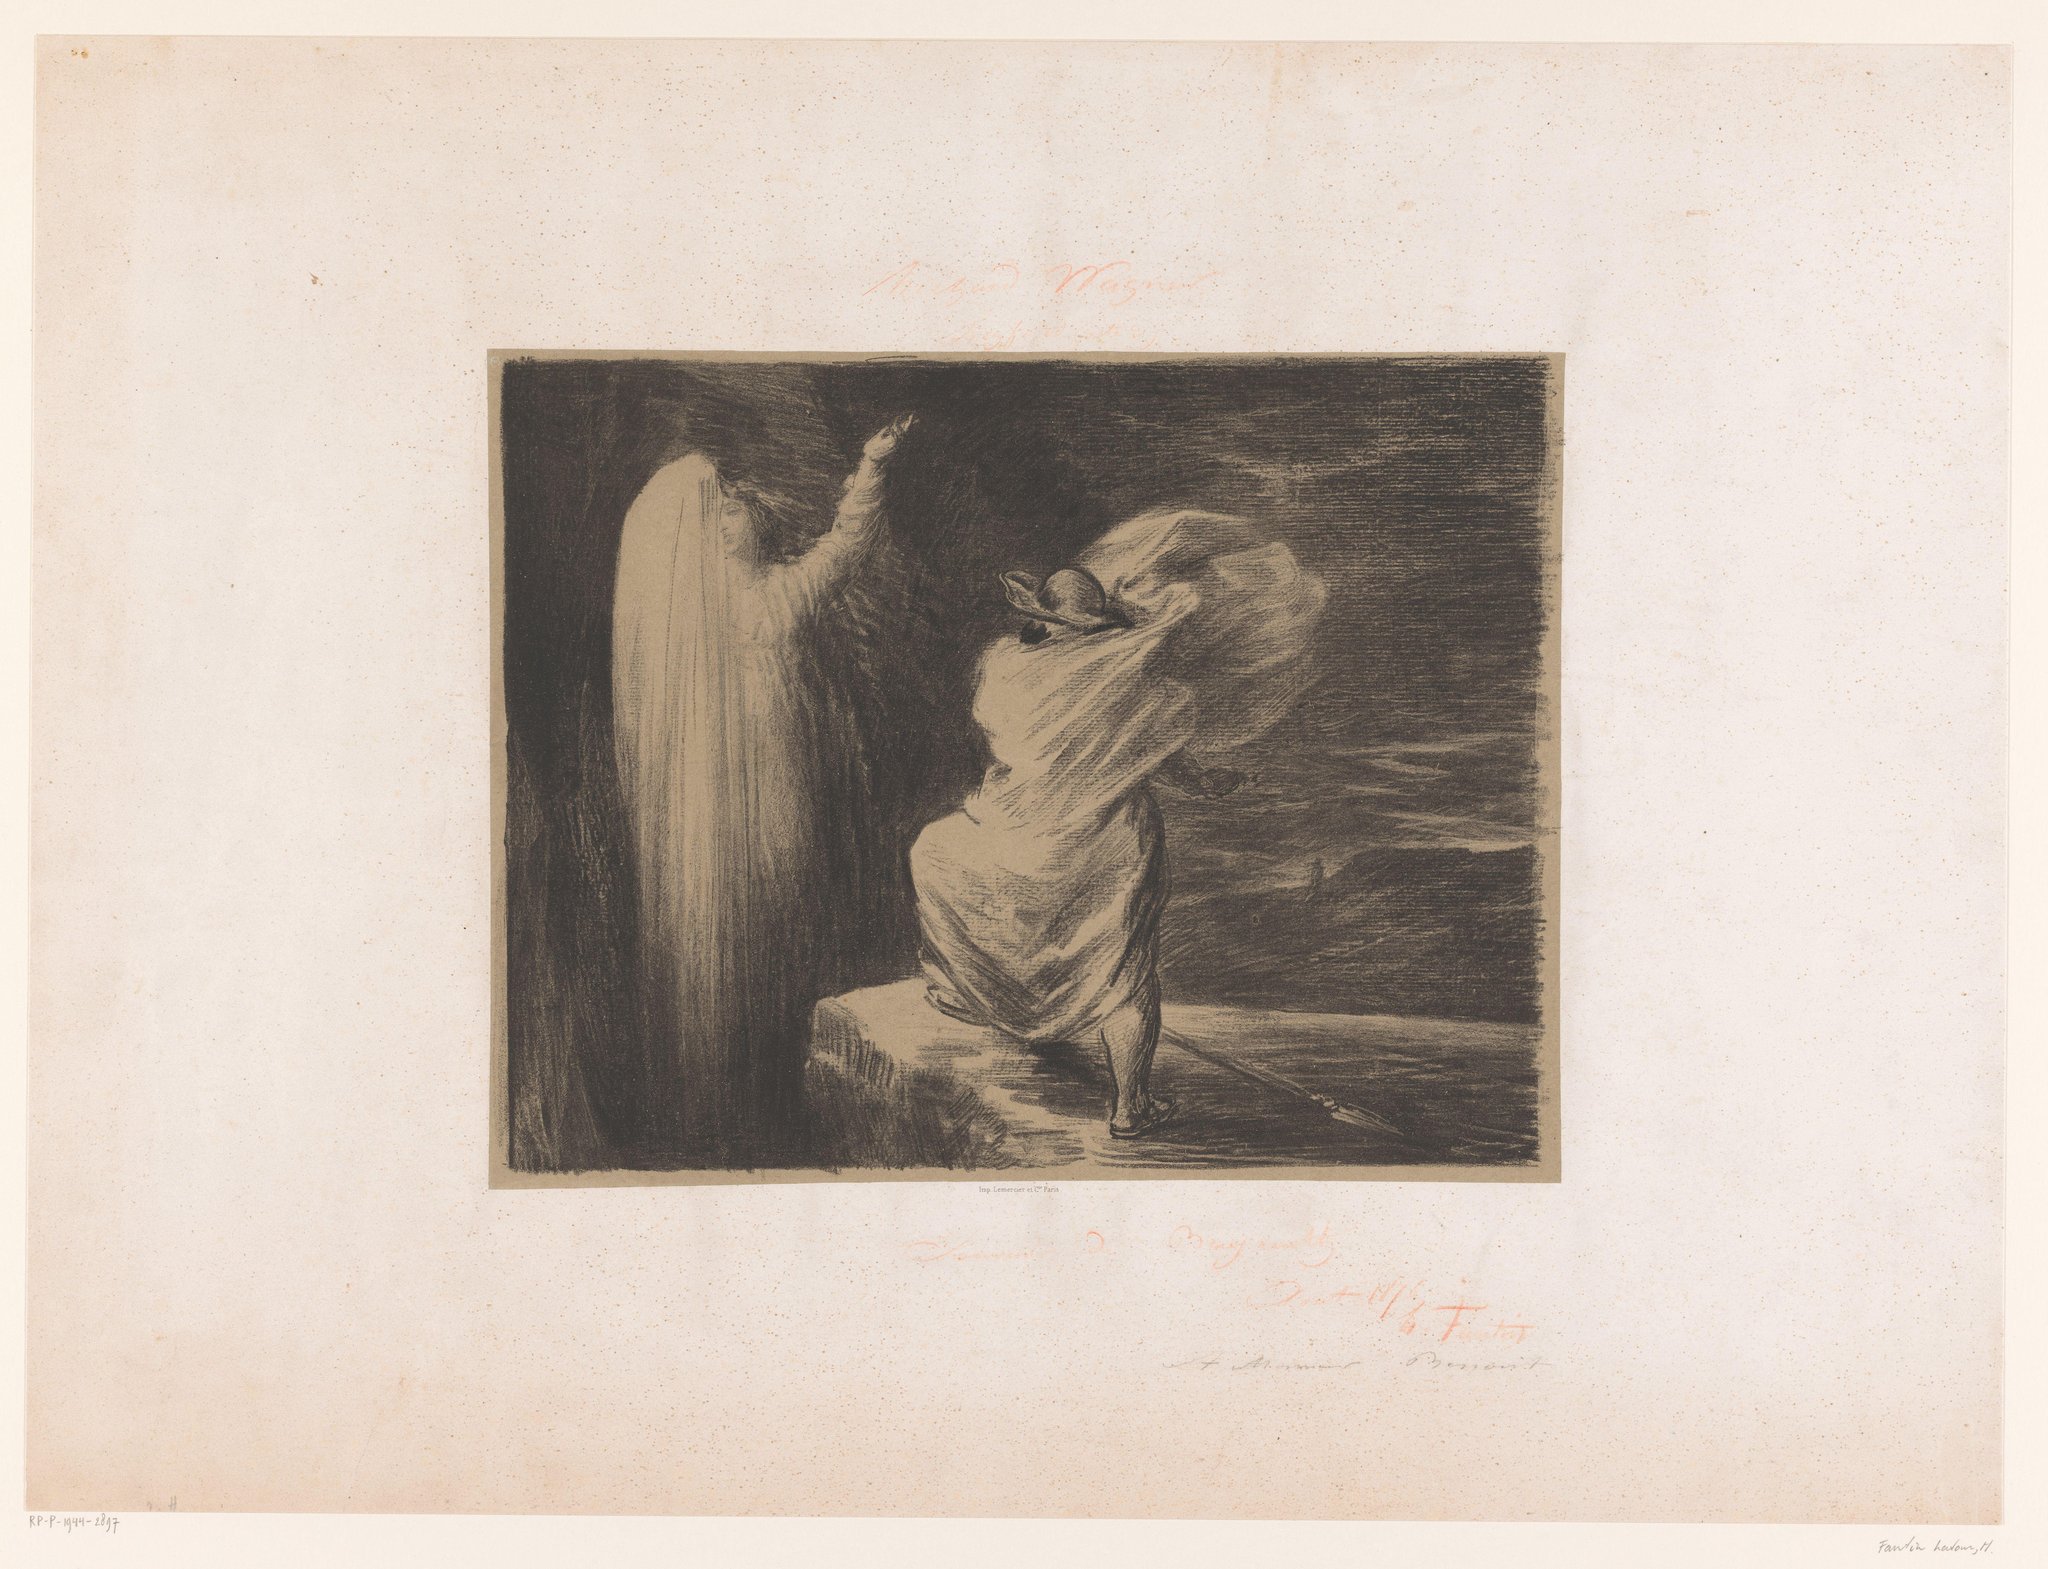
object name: print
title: Siegfried. Acte III. Évocation d'Erda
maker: henri fantin-latour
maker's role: draughtsman, print maker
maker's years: 1836-1904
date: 1876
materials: paper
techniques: lithography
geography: paris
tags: evoking ghosts, conjuring up spirits, calling up genii, bad omen; 'augurio cattivo' (ripa), 'nibelungenlied'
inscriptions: collector's mark: Lugt 2228a, collector's mark: Lugt 2760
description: Wotan roept Erda op om haar advies in te winnen.